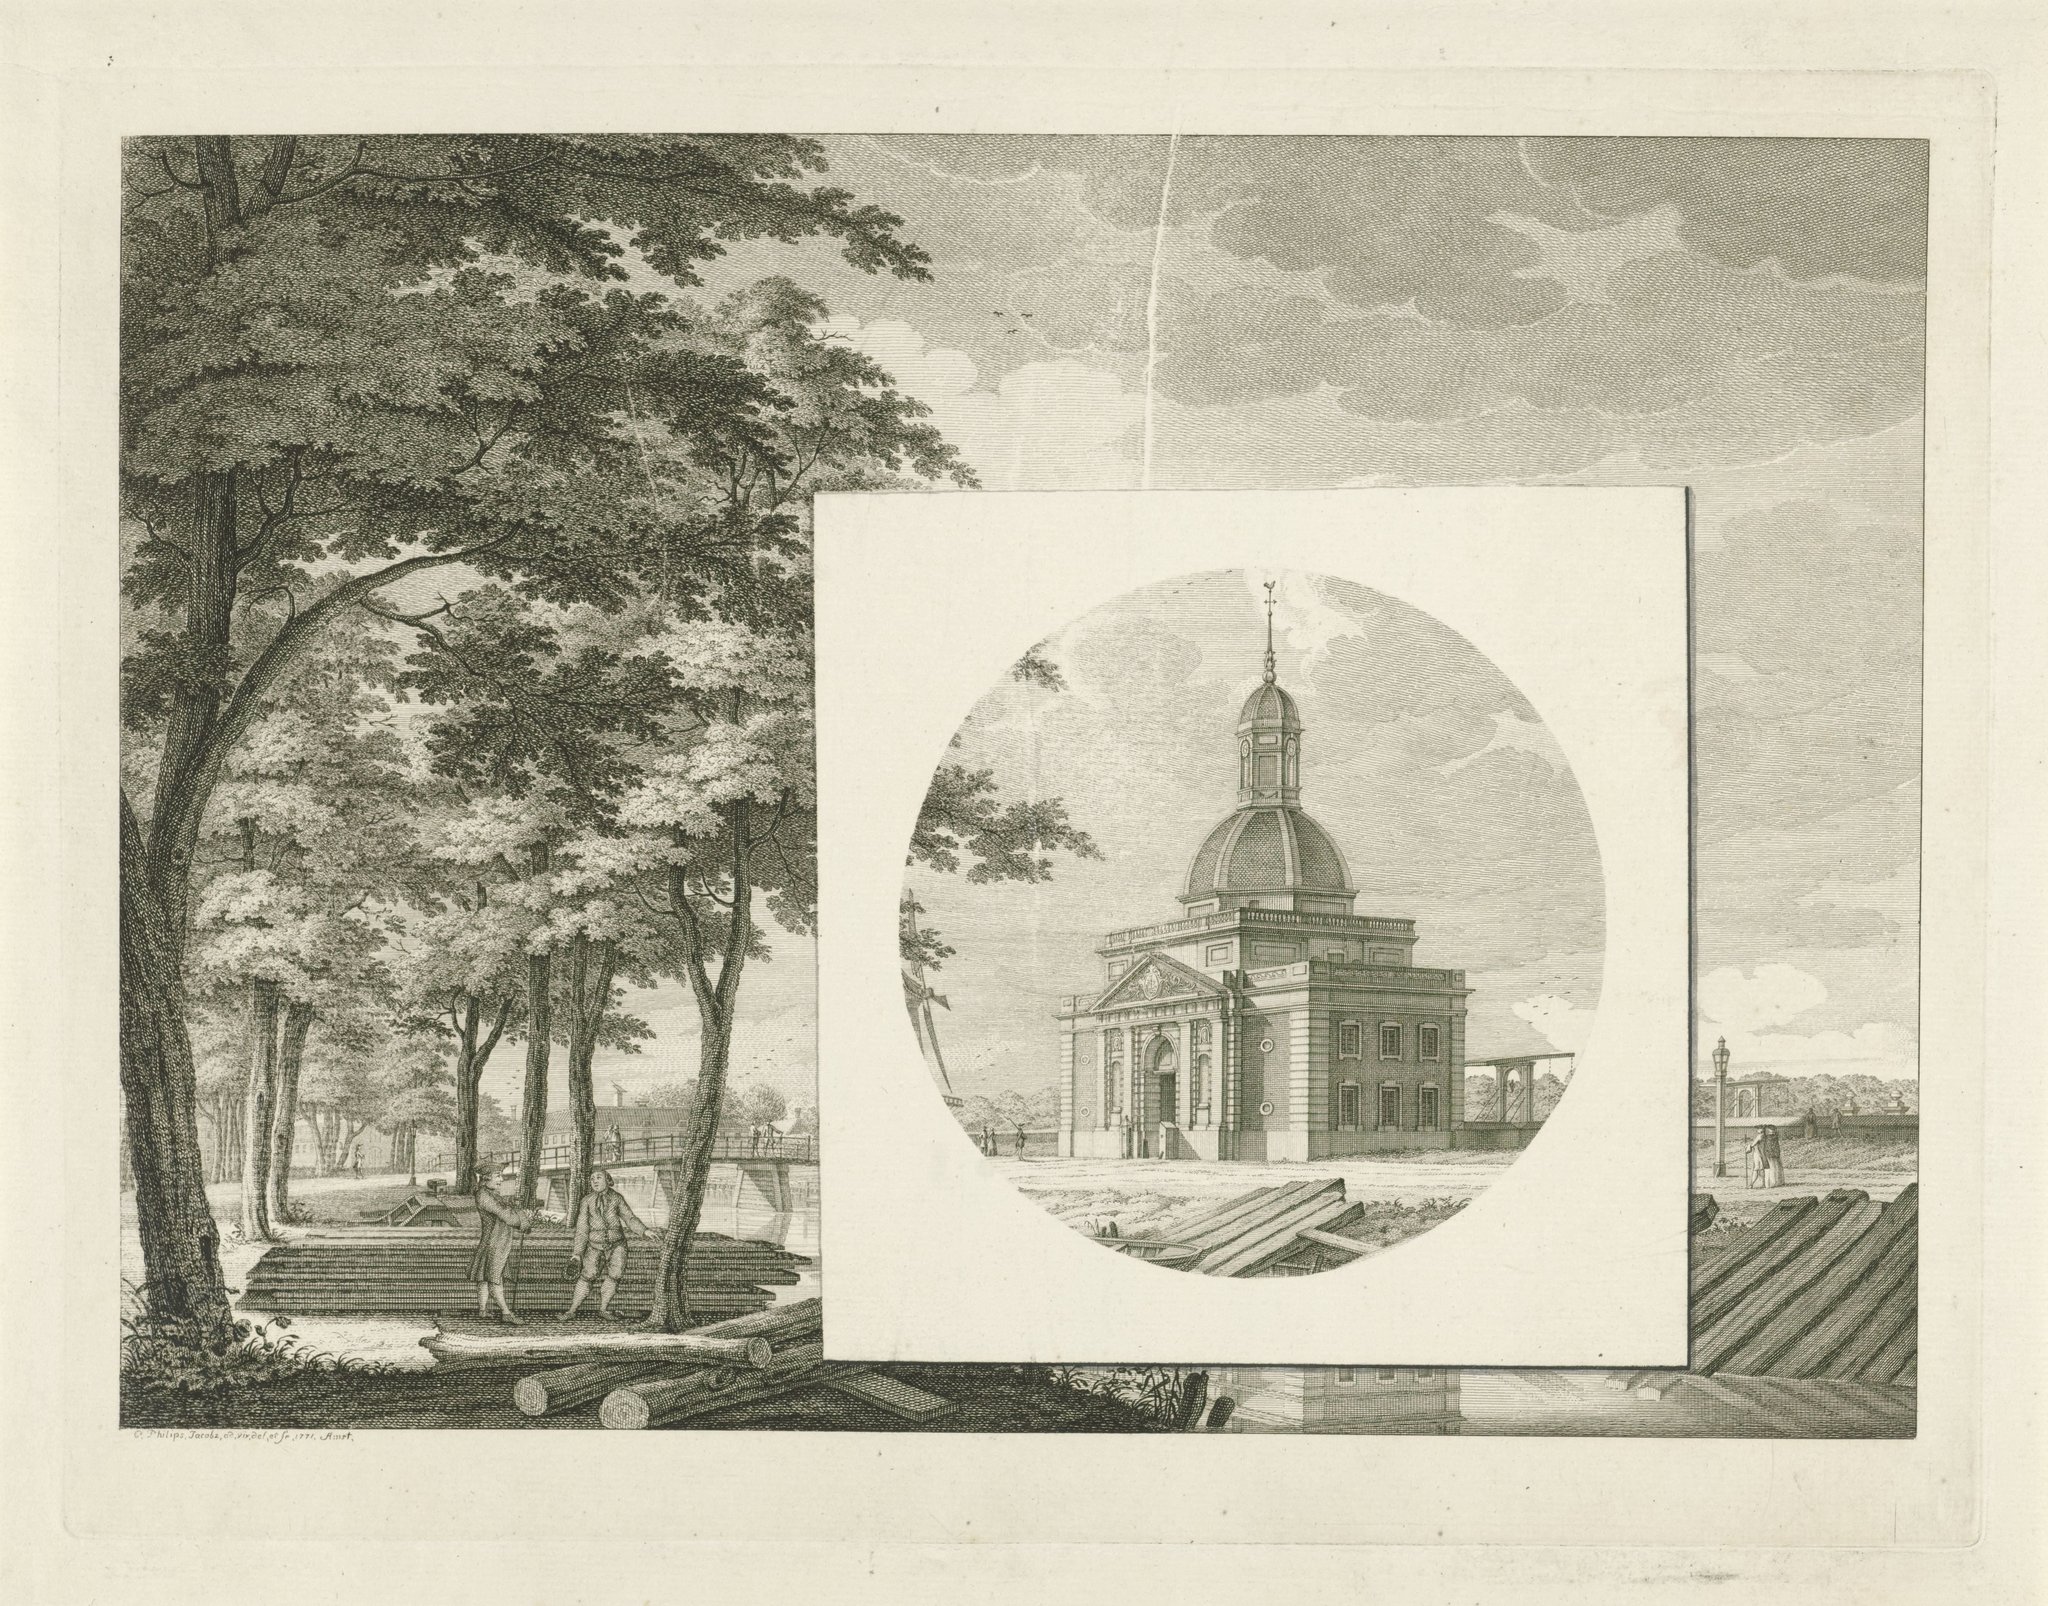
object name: print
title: Gezicht op de nieuw gebouwde Muiderpoort, 1771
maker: caspar jacobsz. philips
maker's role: draughtsman, print maker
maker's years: 1732-1789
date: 1771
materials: ink, paper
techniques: brush, etching, pen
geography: amsterdam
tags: city-gate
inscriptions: collector's mark: Lugt 2228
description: Gezicht vanaf de Plantage op de nieuw gebouwde Muiderpoort, 1771. Om het gebouw heen een rond kader dat meegedrukt is op de voorstelling (een schijnbedrieger).